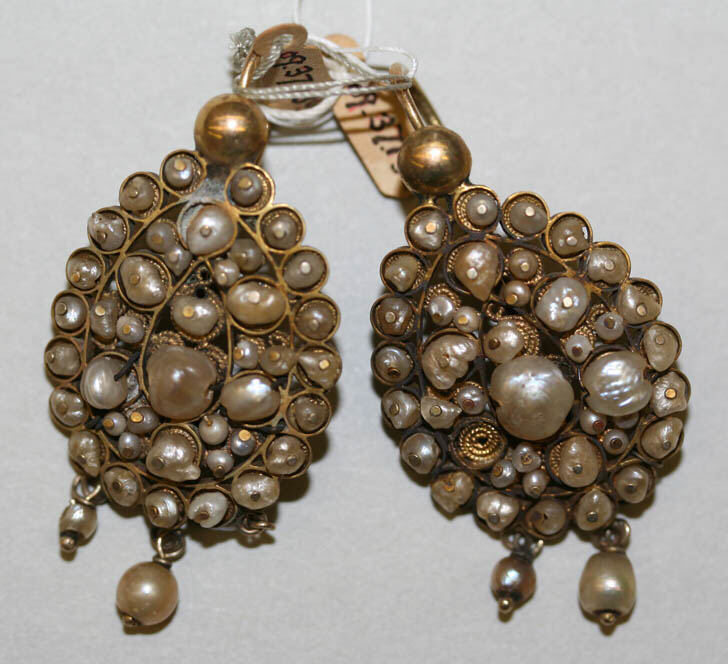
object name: earring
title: Earrings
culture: european, eastern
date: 1701-1900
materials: metal